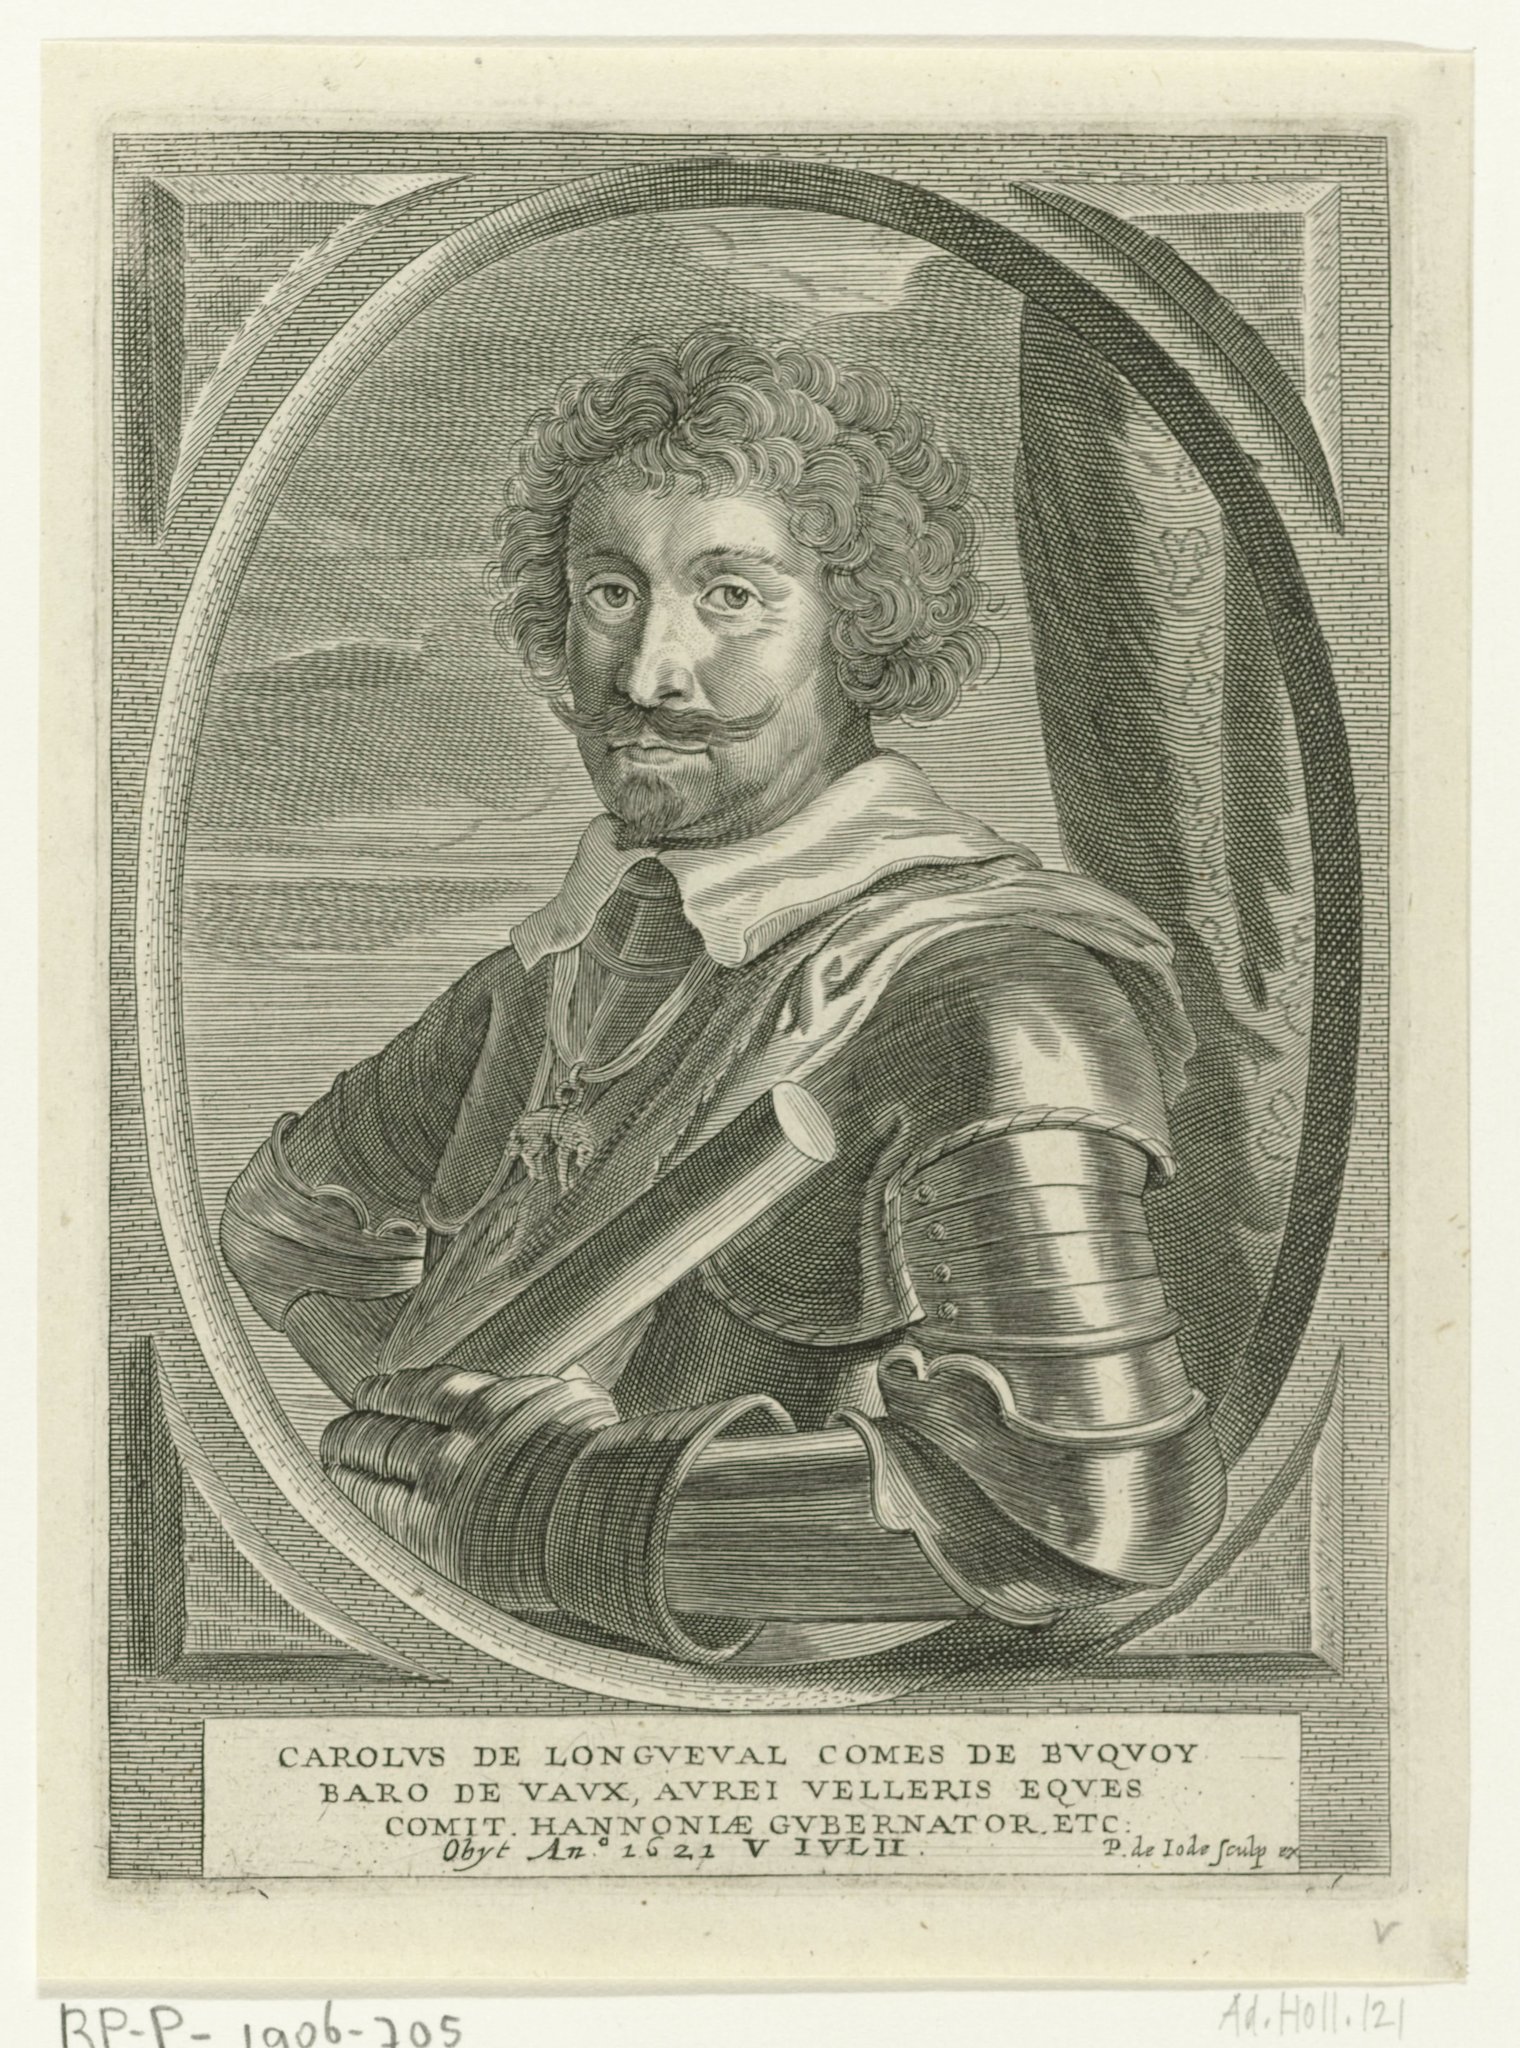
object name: print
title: Theatrum pontificum, imperatorum, regum, ducum, principum, etc.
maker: pieter de jode (ii)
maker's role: draughtsman, print maker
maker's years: 1606-1674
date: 1628-1670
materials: paper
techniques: engraving, etching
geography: antwerp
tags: arras, nové zámky, bevelhebber, karel bonaventura van longueval (graaf van bucquoy)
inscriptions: collector's mark: Lugt 2228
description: Busteportret van Karel de Longueval, graaf van Bucquoy, in harnas. In zijn rechterhand houdt hij een commandostaf en zijn rechterarm steekt uit de omlijsting. Het portret is gevat in een ovale omlijsting met vierkant randwerk. In de marge een vierregelig onderschrift in het Latijn.